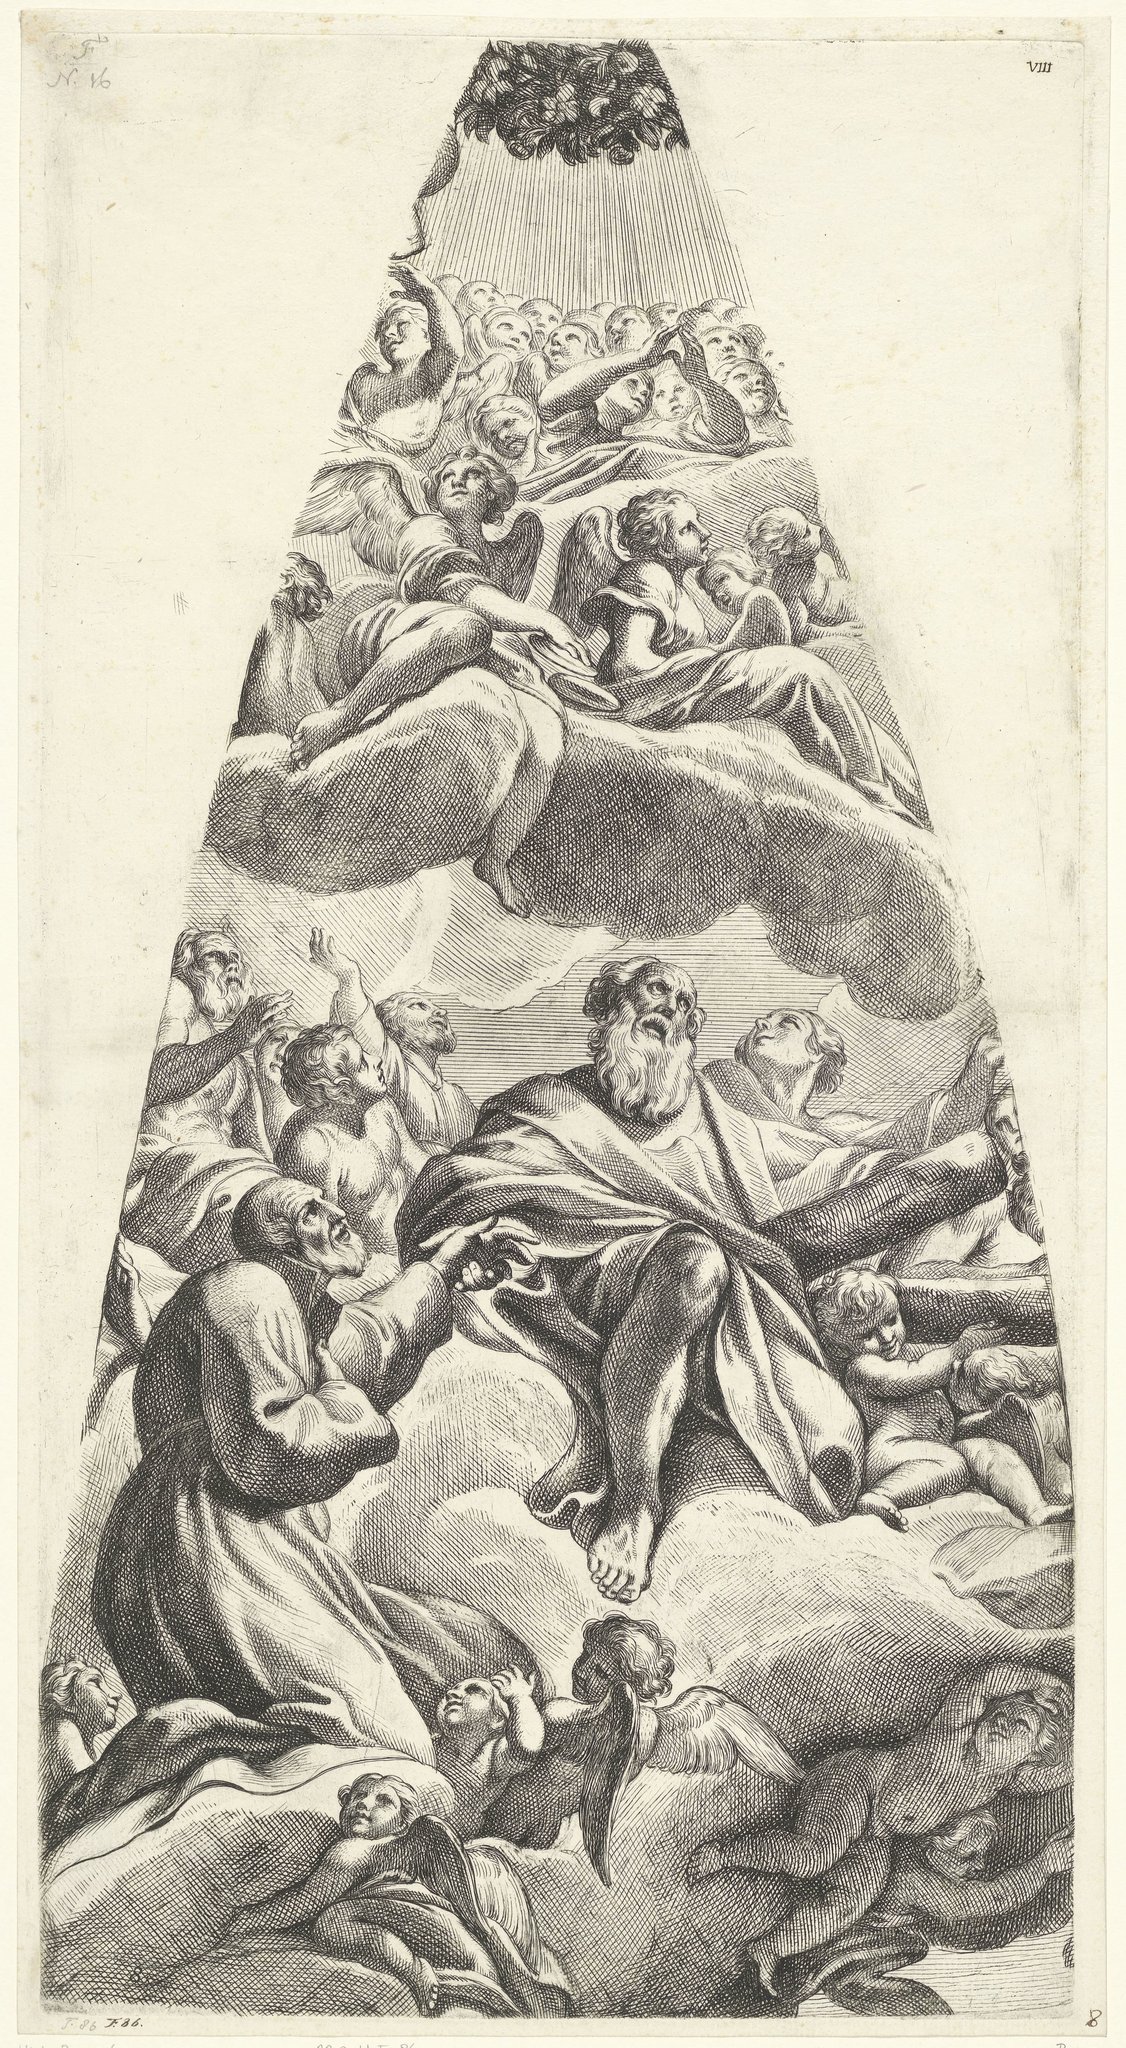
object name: print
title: Hemelvaart van Maria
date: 1680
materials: paper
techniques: engraving, etching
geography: rome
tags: saints, angels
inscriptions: collector's mark: Lugt 10, collector's mark: ‘Hinloopen’, collector's mark: Lugt 11, number: ‘8’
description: Prent uit een reeks van 8 prenten naar de fresco's door Giovanni Lanfranco in de koepel van de San Andrea della Valle te Rome.